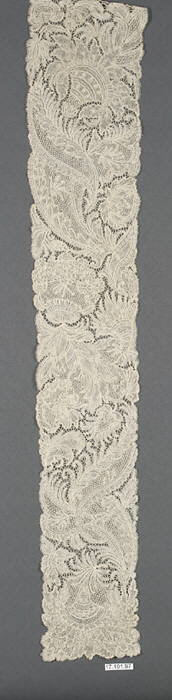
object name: cap border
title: Cap trimming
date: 1701-1733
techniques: lace